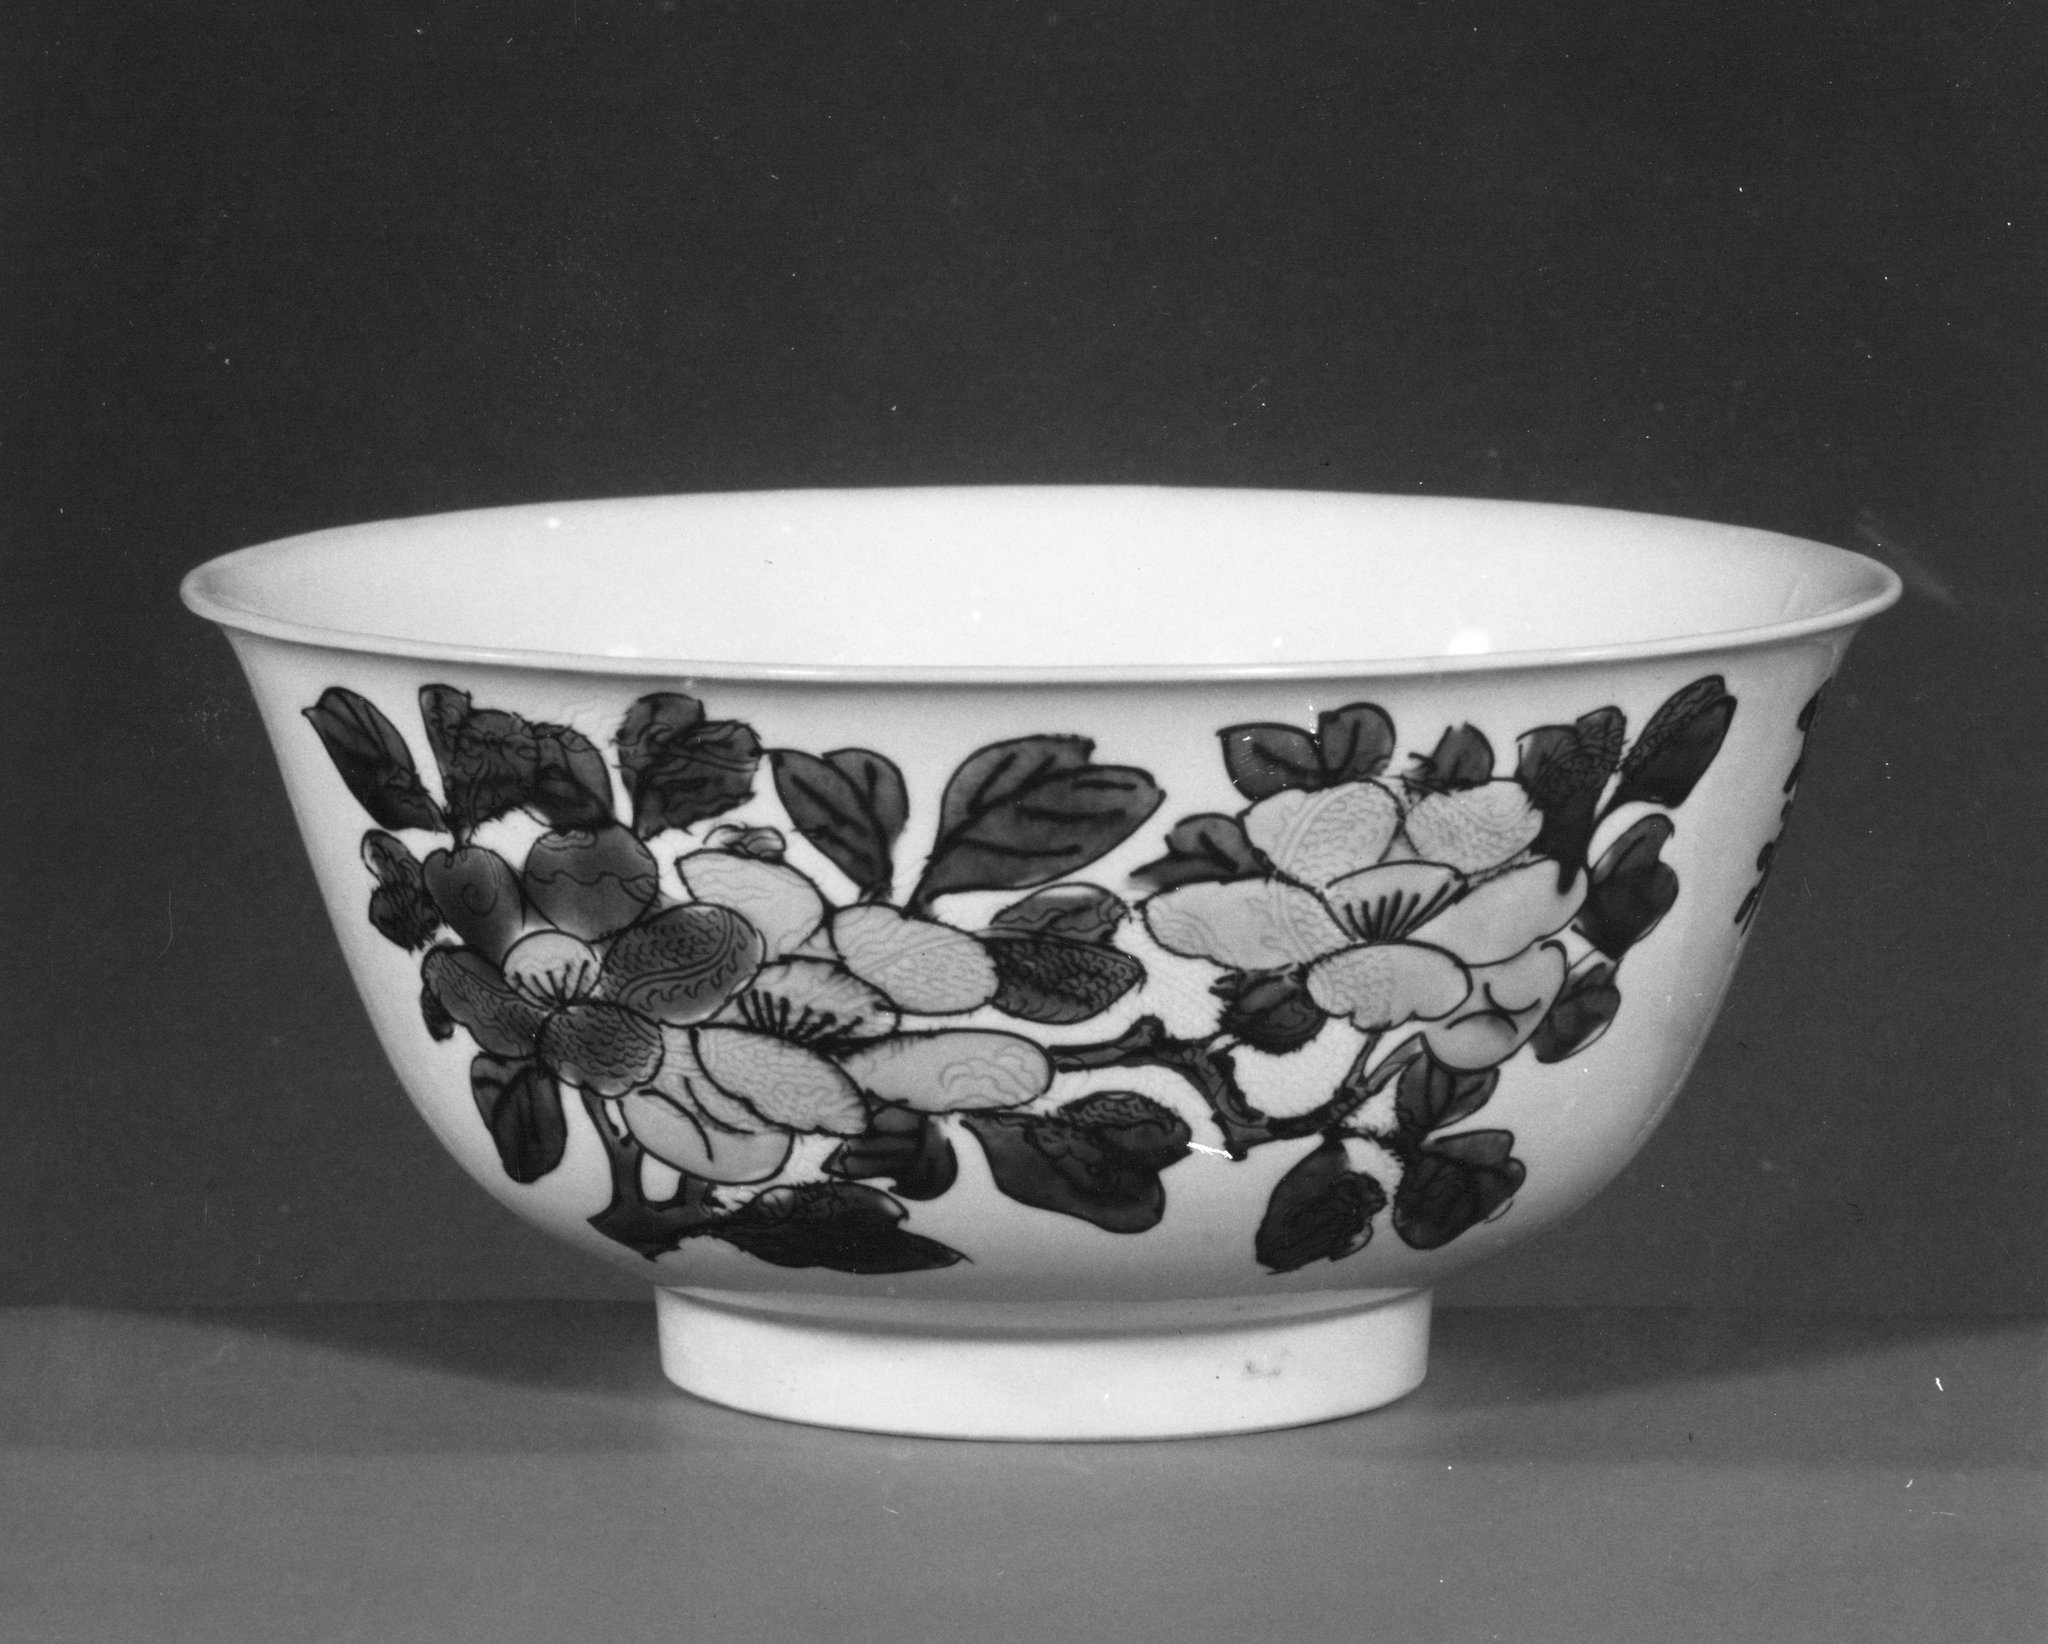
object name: bowl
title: Bowl (one of a pair)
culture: chinese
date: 1662-1722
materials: biscuit, enamel, porcelain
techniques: painting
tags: flowers,leaves